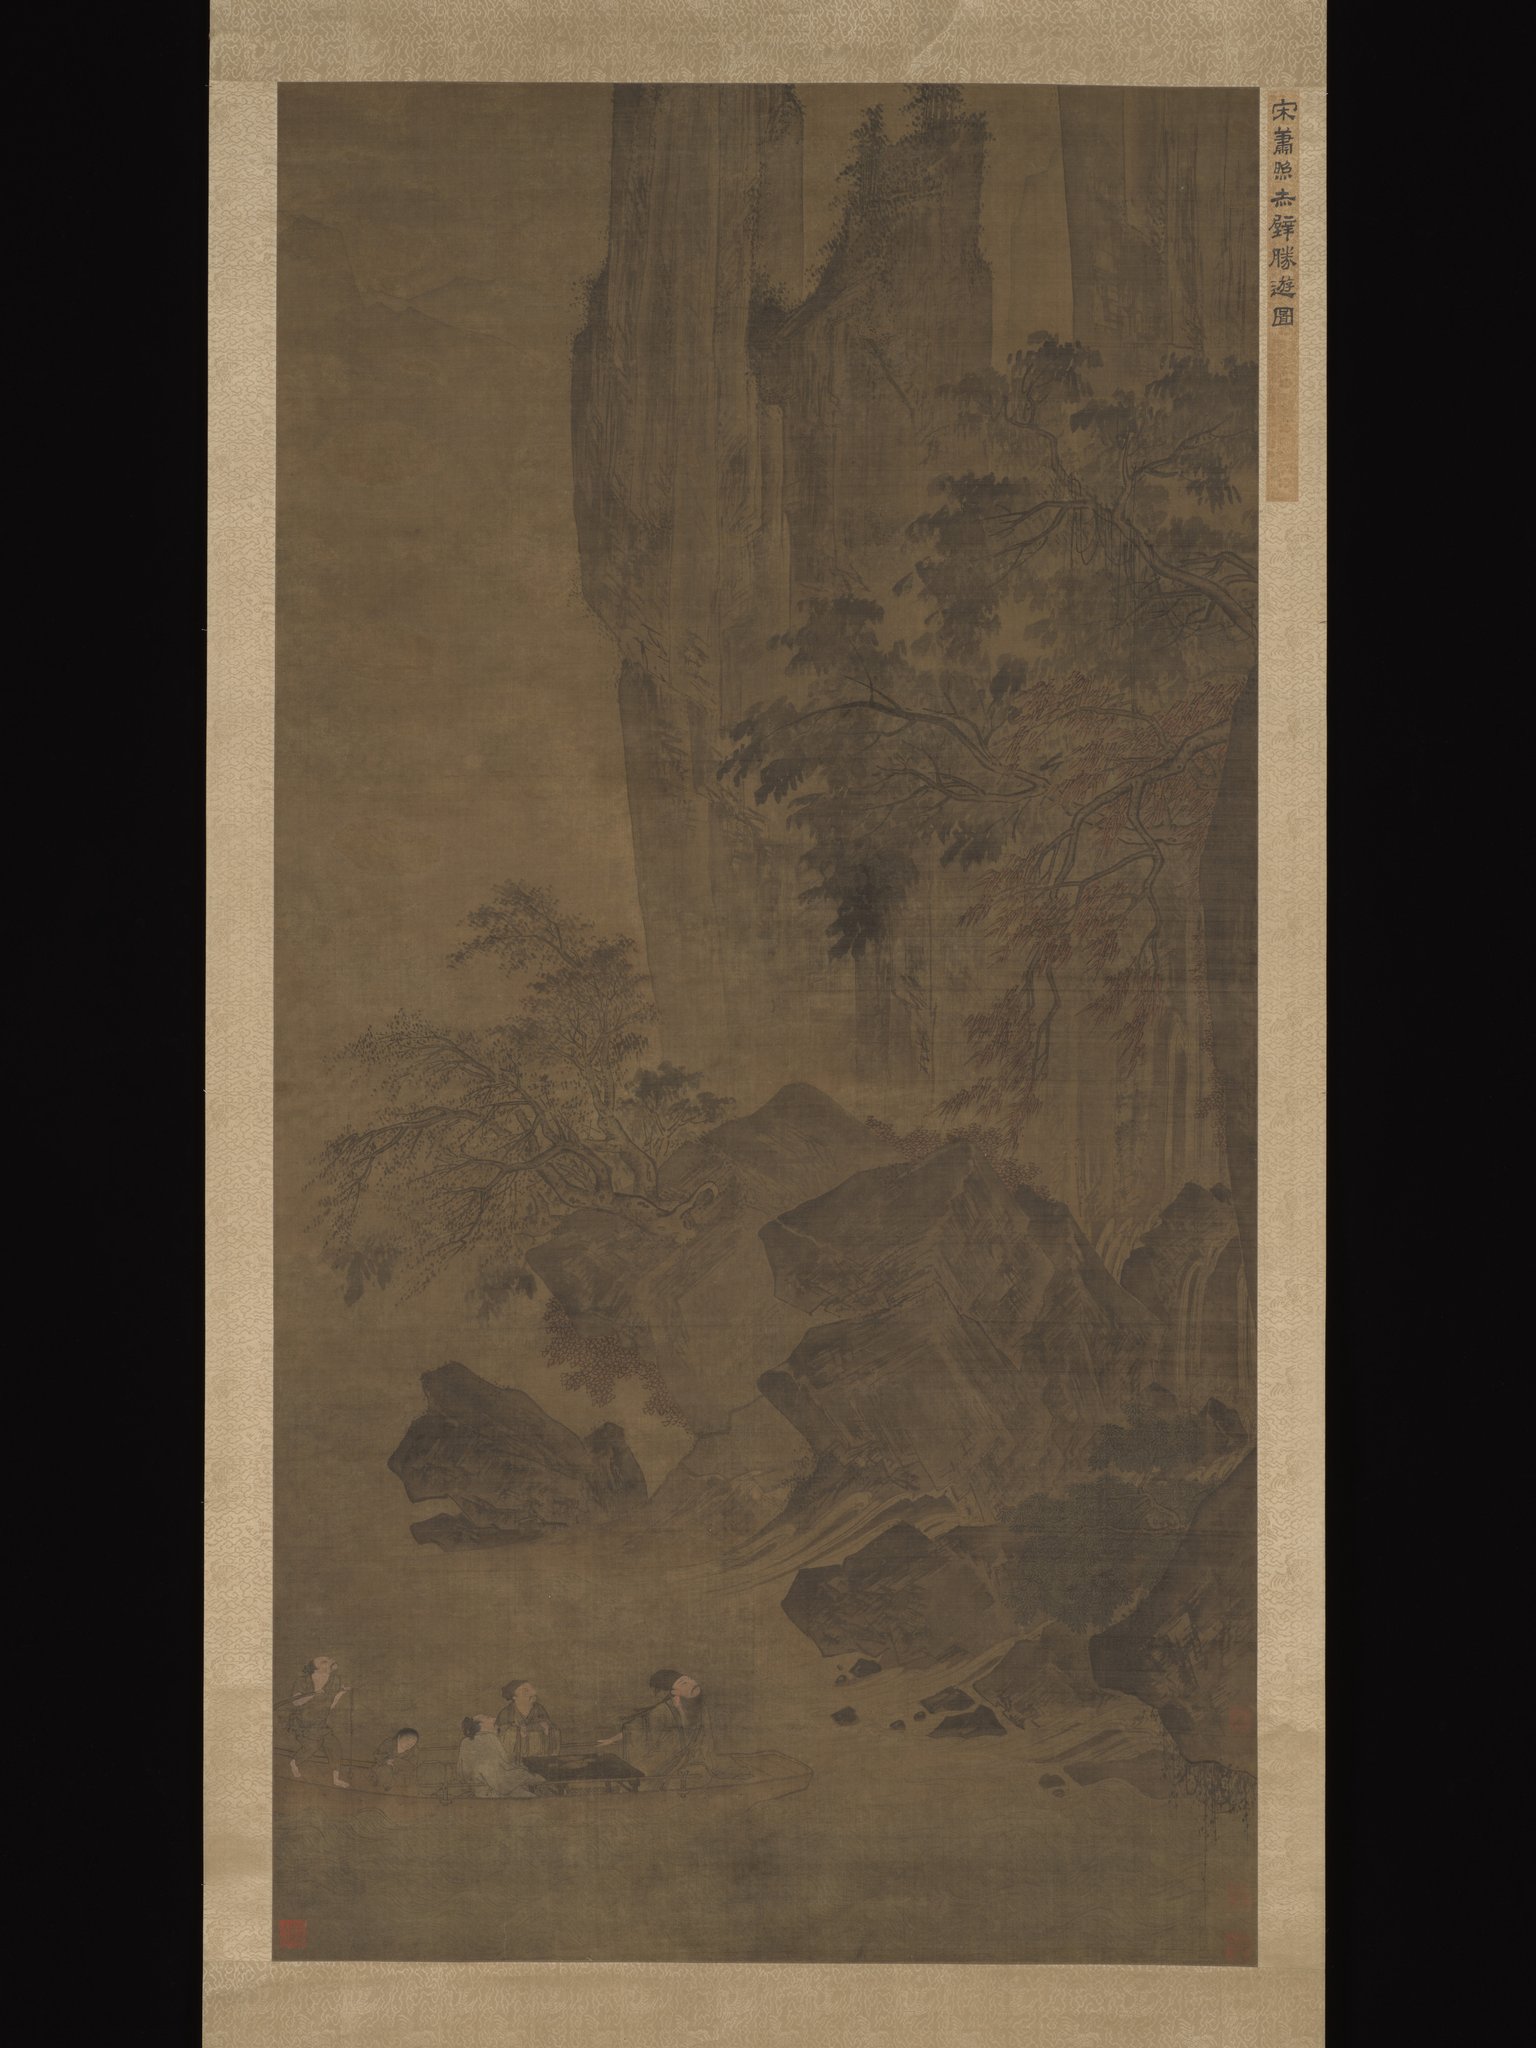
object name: hanging scroll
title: Su Dongbo's Visit to Chibi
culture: chinese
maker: unidentified artist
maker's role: artist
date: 1368-1911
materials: silk